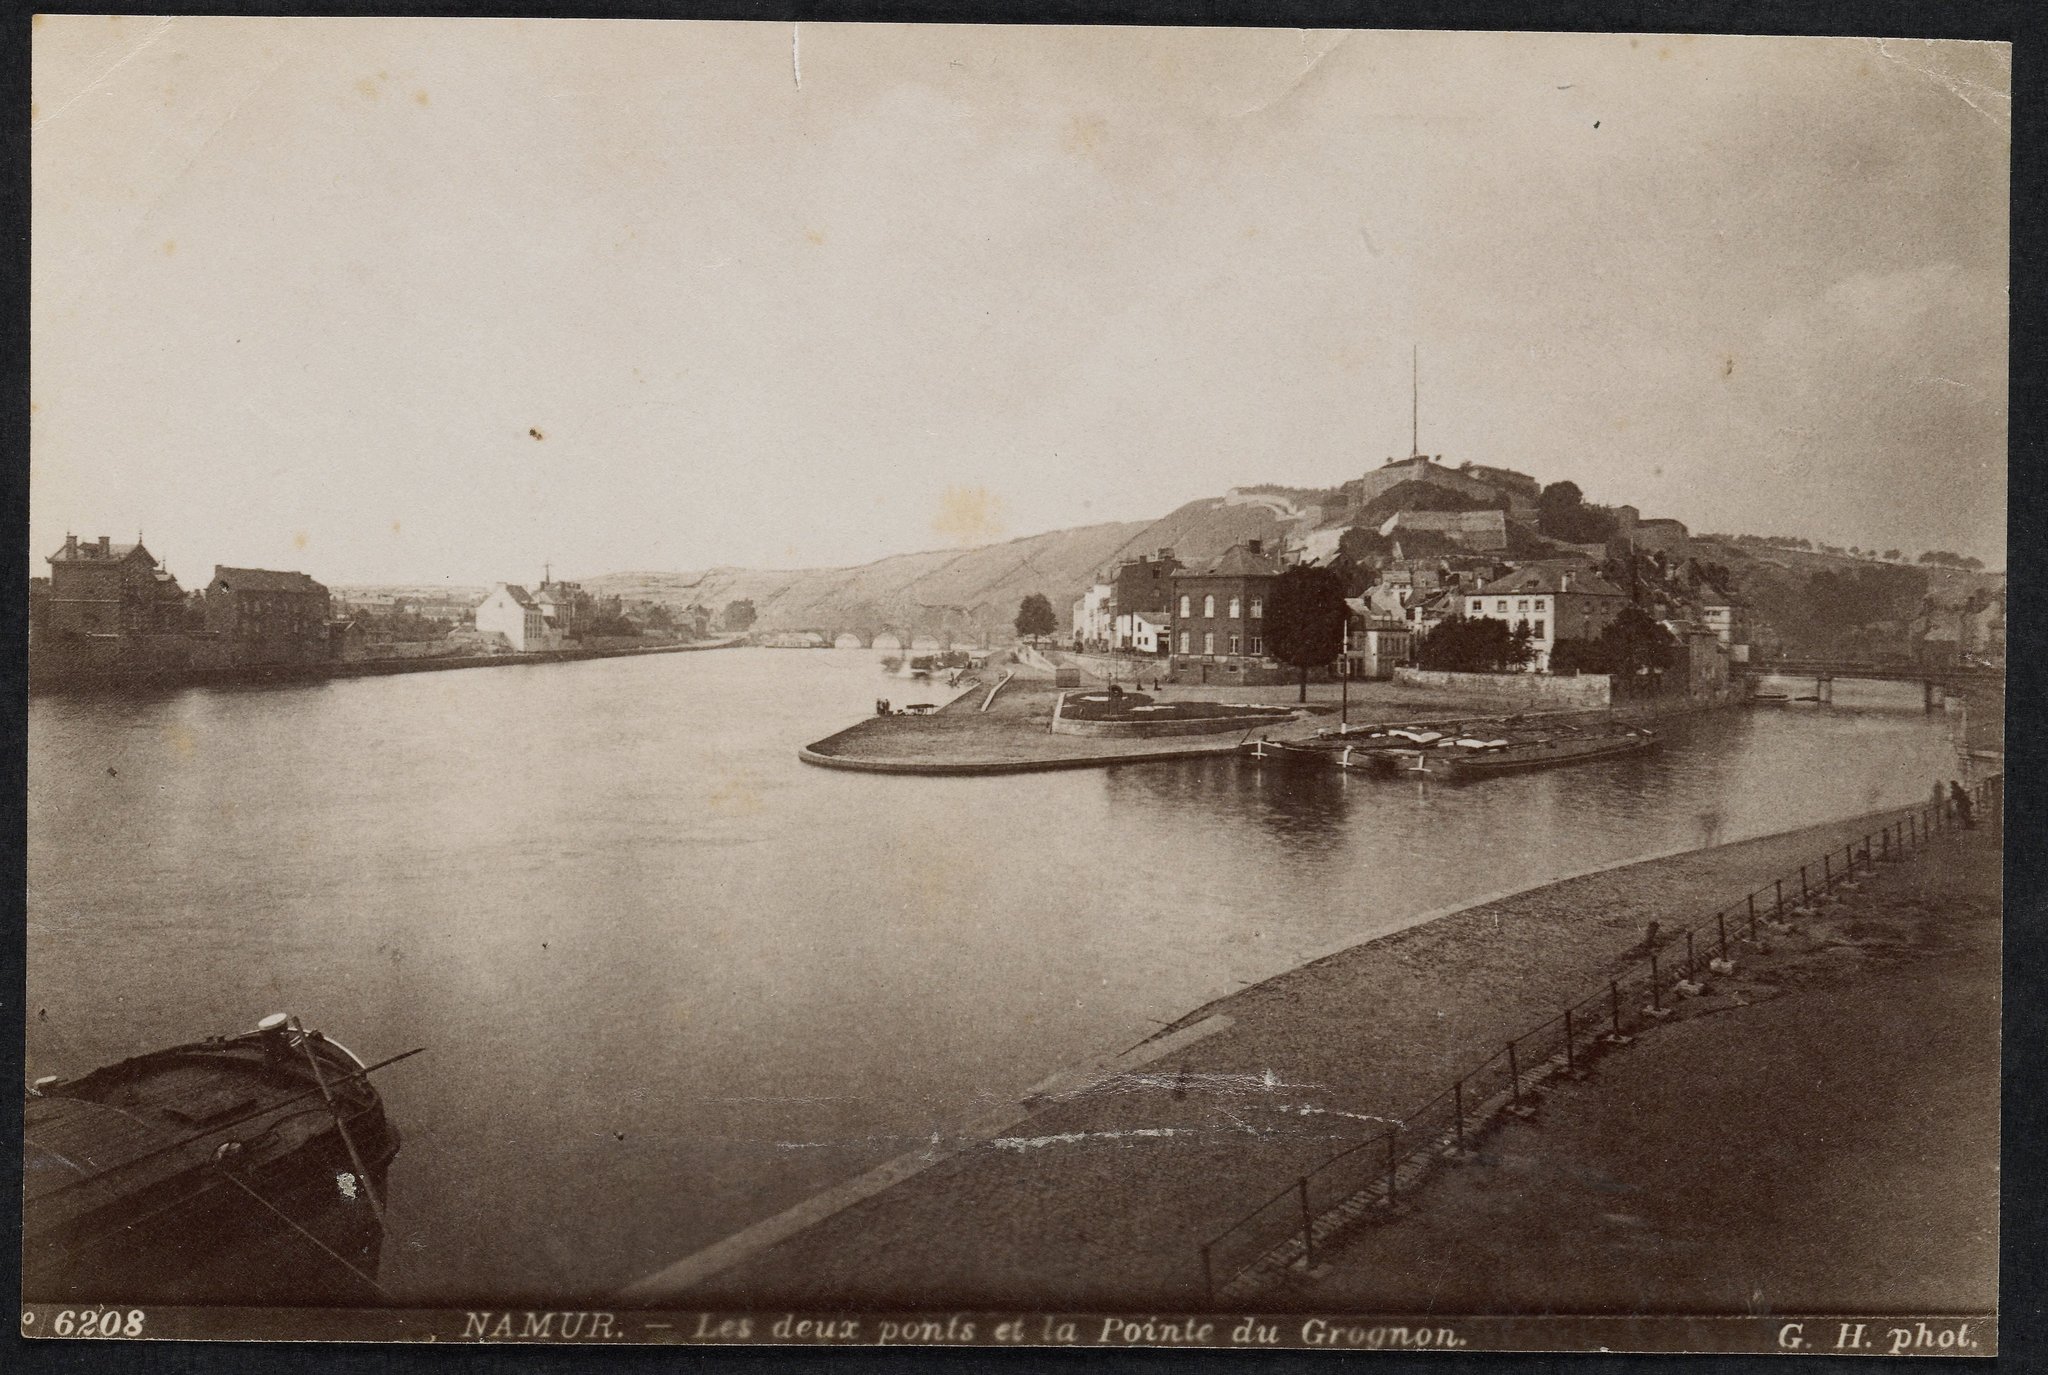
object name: photograph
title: Namur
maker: gustave hermans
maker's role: publisher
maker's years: 1856-1934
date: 1884-1914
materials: paper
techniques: albumen print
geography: namur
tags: city-view in general; 'veduta', river, fortified city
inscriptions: number: ‘No 6208’